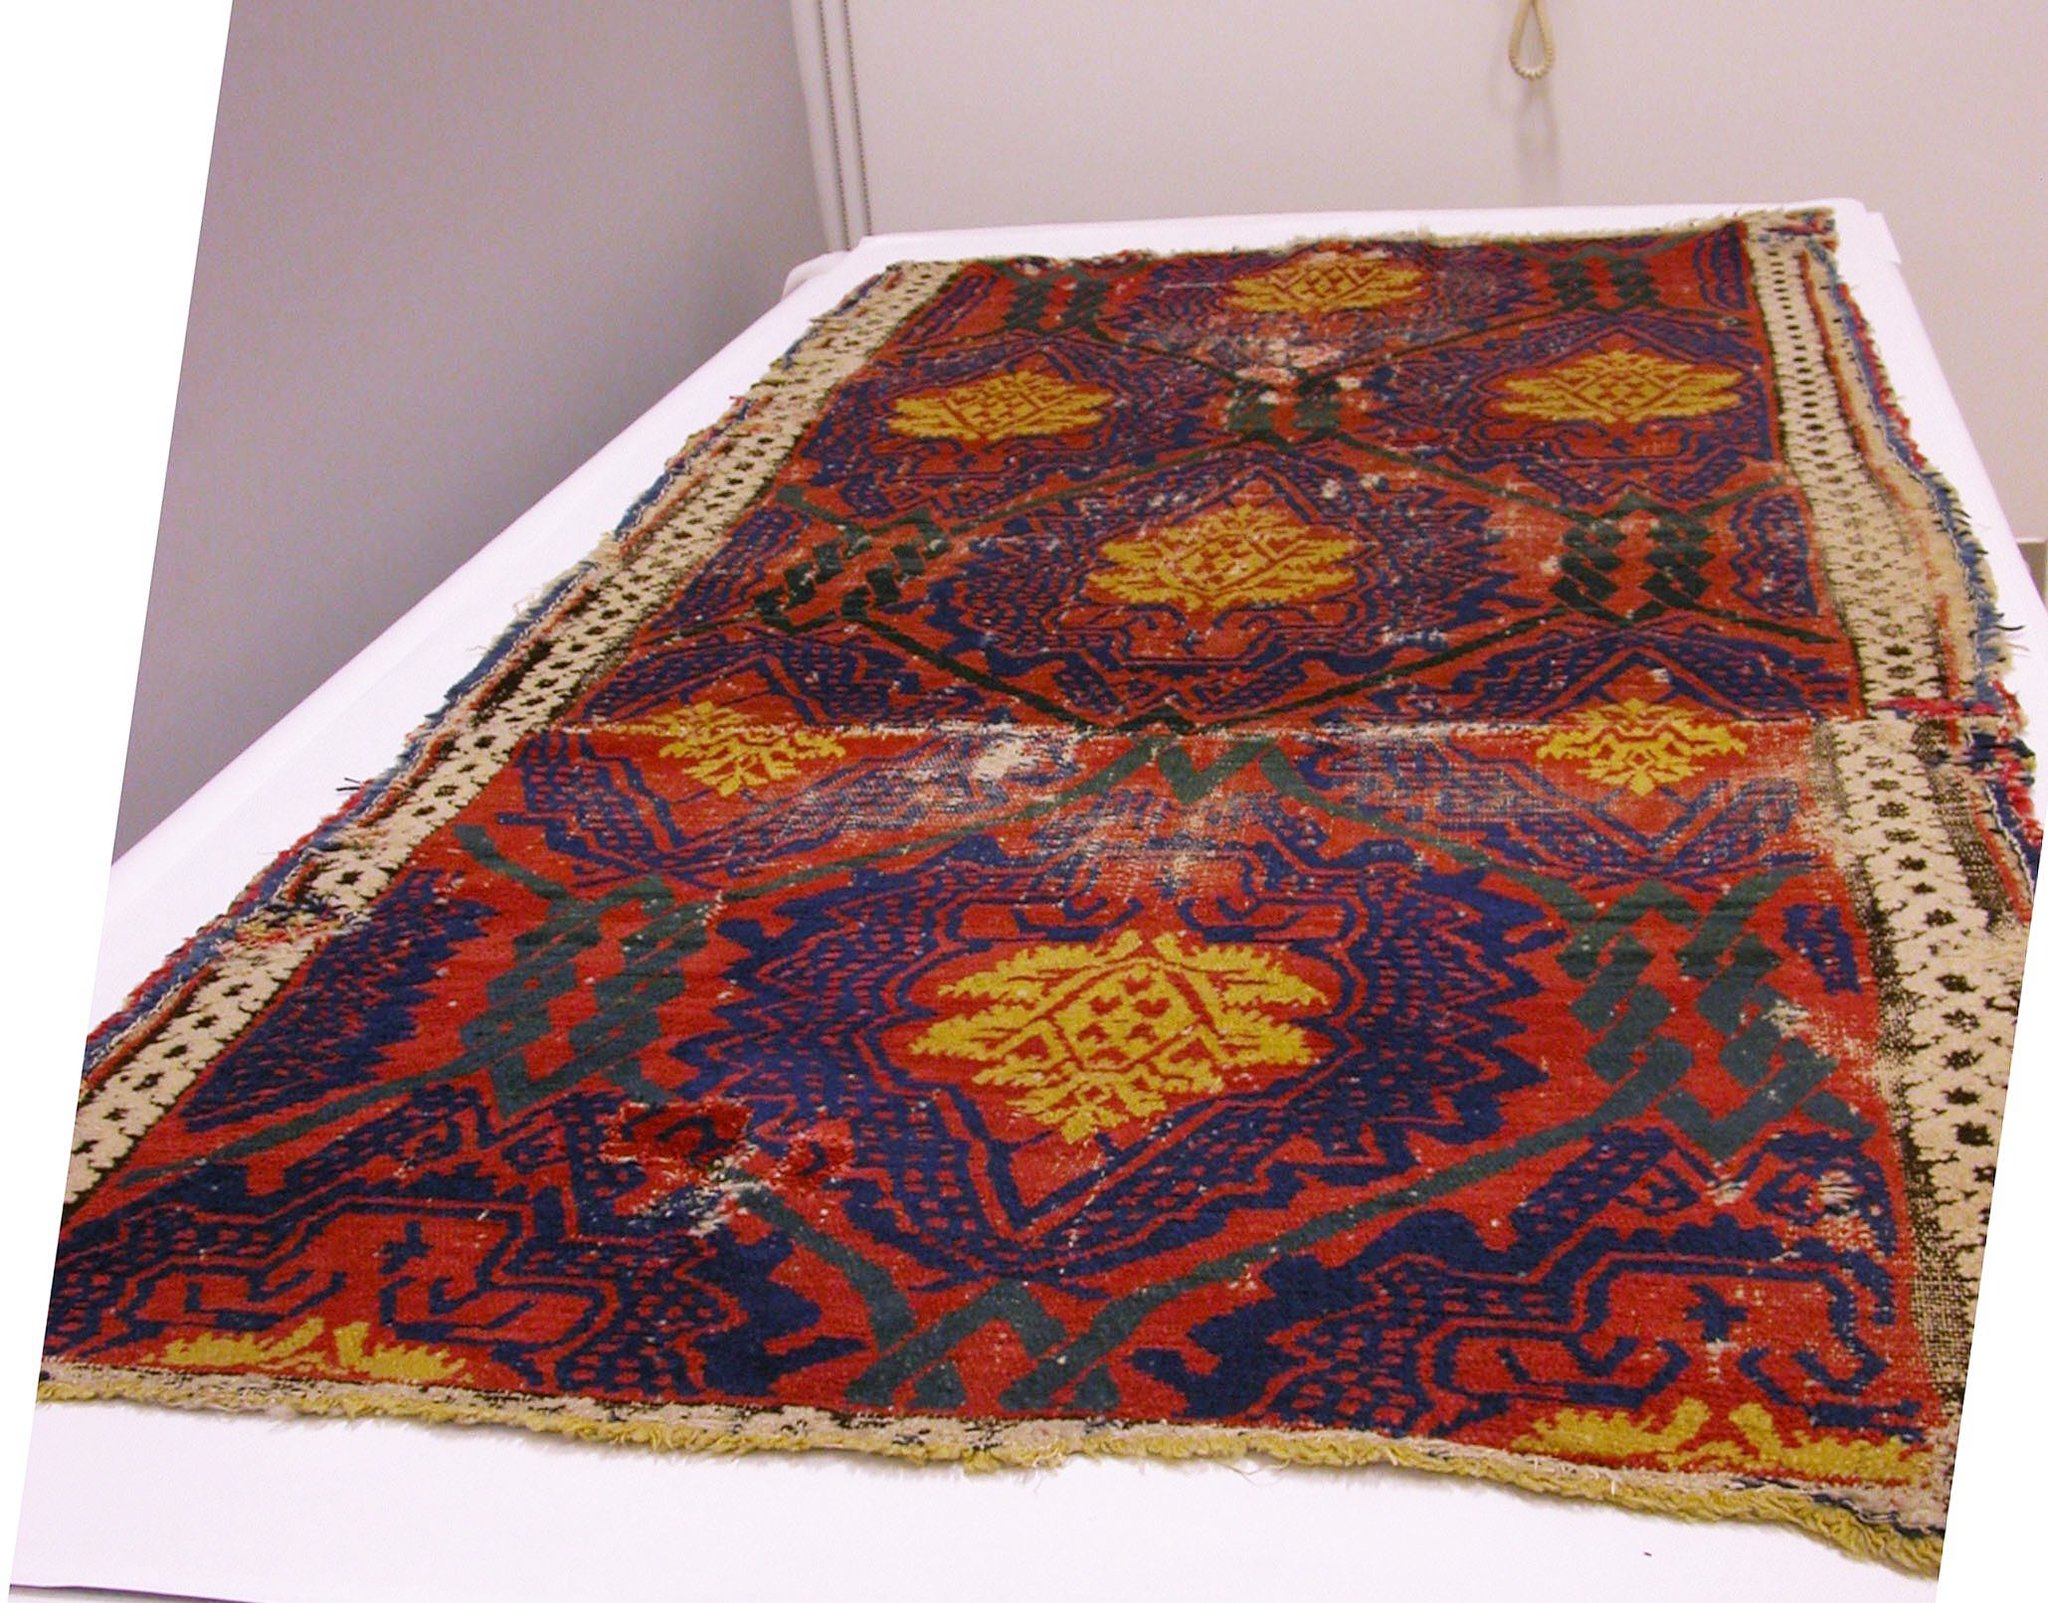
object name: carpet fragment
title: Joined Carpet Fragments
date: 1401-1600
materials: wool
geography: spain